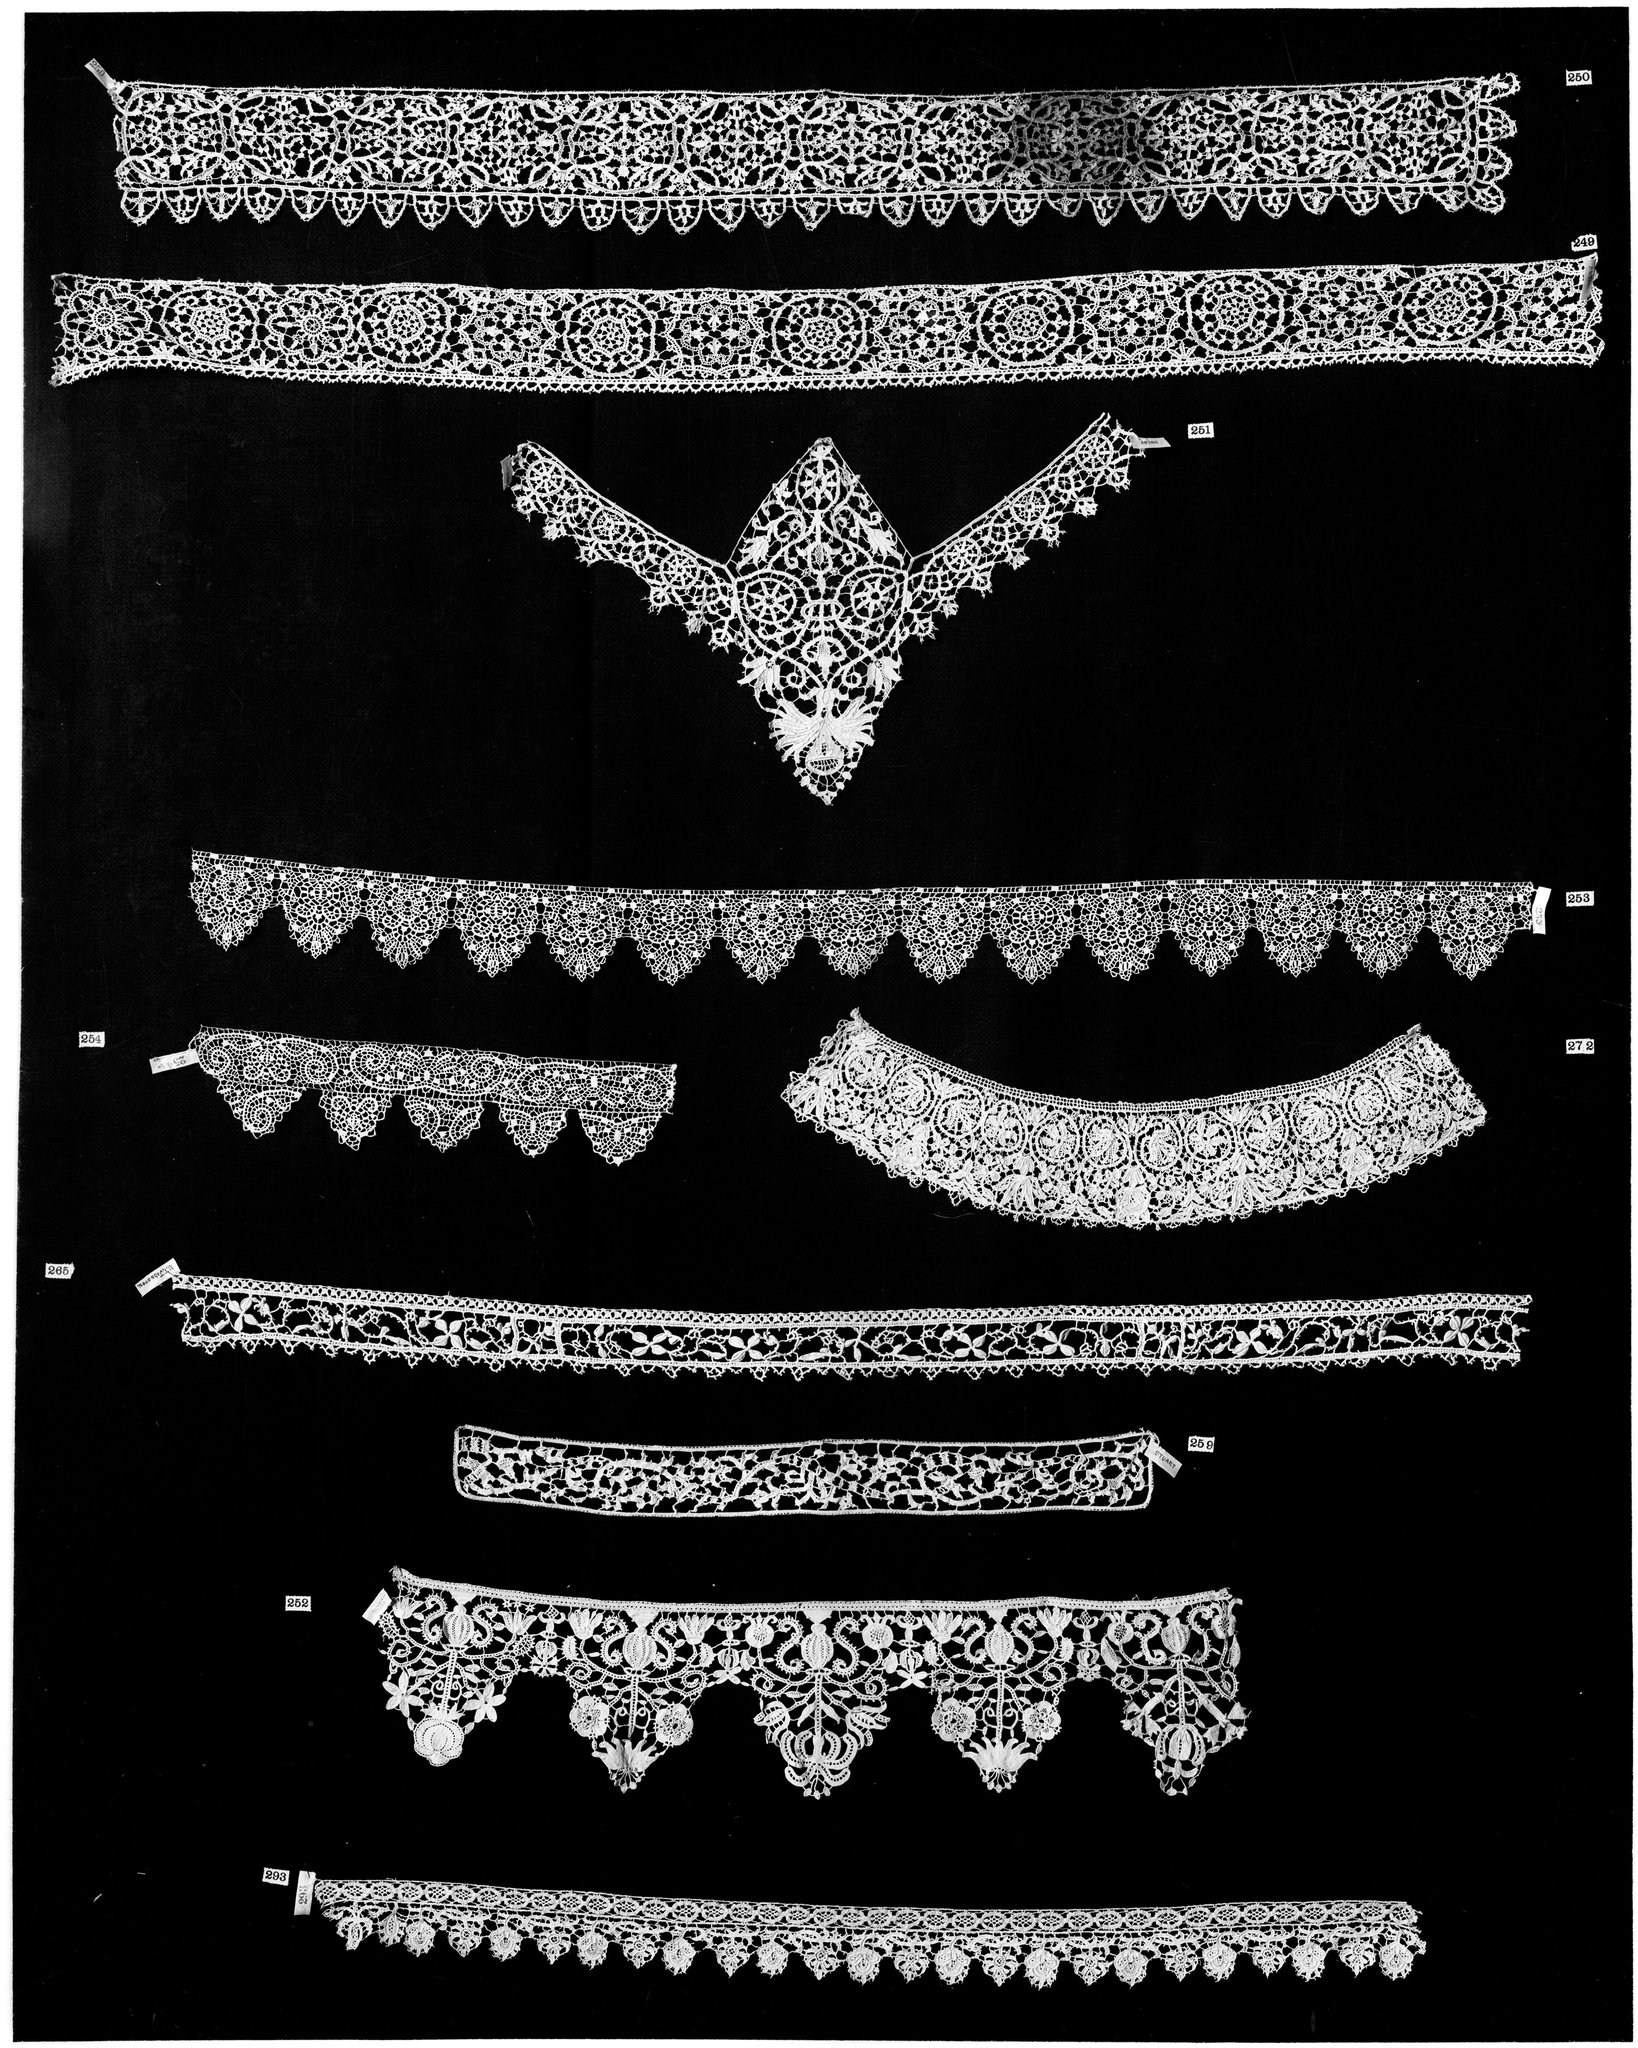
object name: strip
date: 1834-1866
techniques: lace